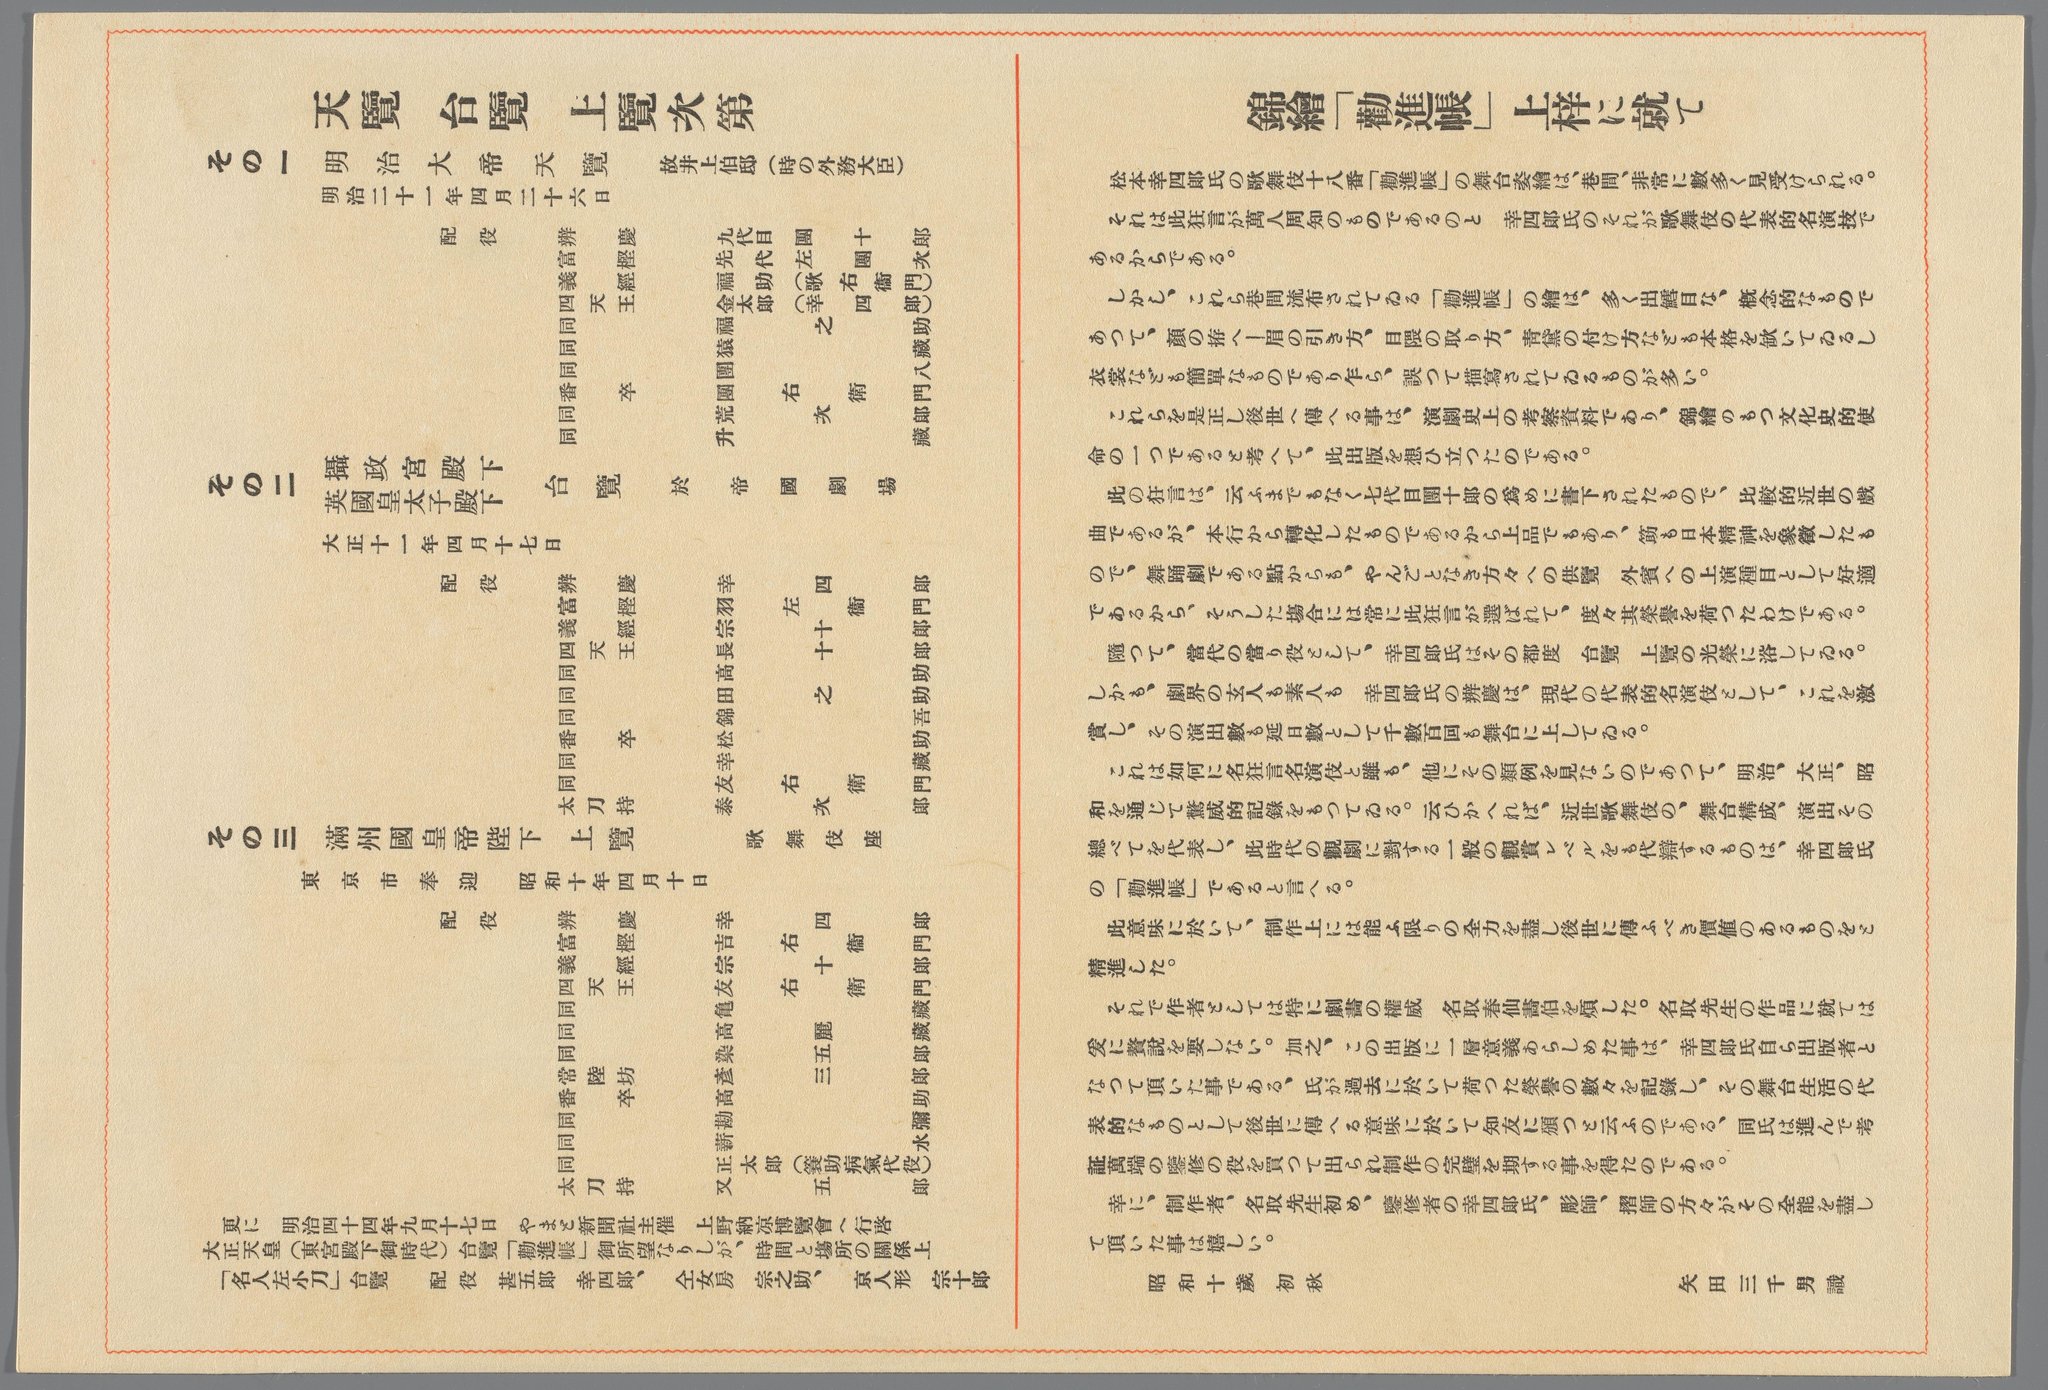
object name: print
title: Originele folder bij prent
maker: natori shunsen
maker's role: print maker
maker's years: 1886-1960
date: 1935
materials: paper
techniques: woodcut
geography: japan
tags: portrait of actor, actress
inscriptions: signature: ‘Shunsen’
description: Originele map waar het tweeluik in verkocht werd waarop de acteur Matsumoto Kóshiró VII in de rol van de Musashi-bó Benkei staat afgebeeld.